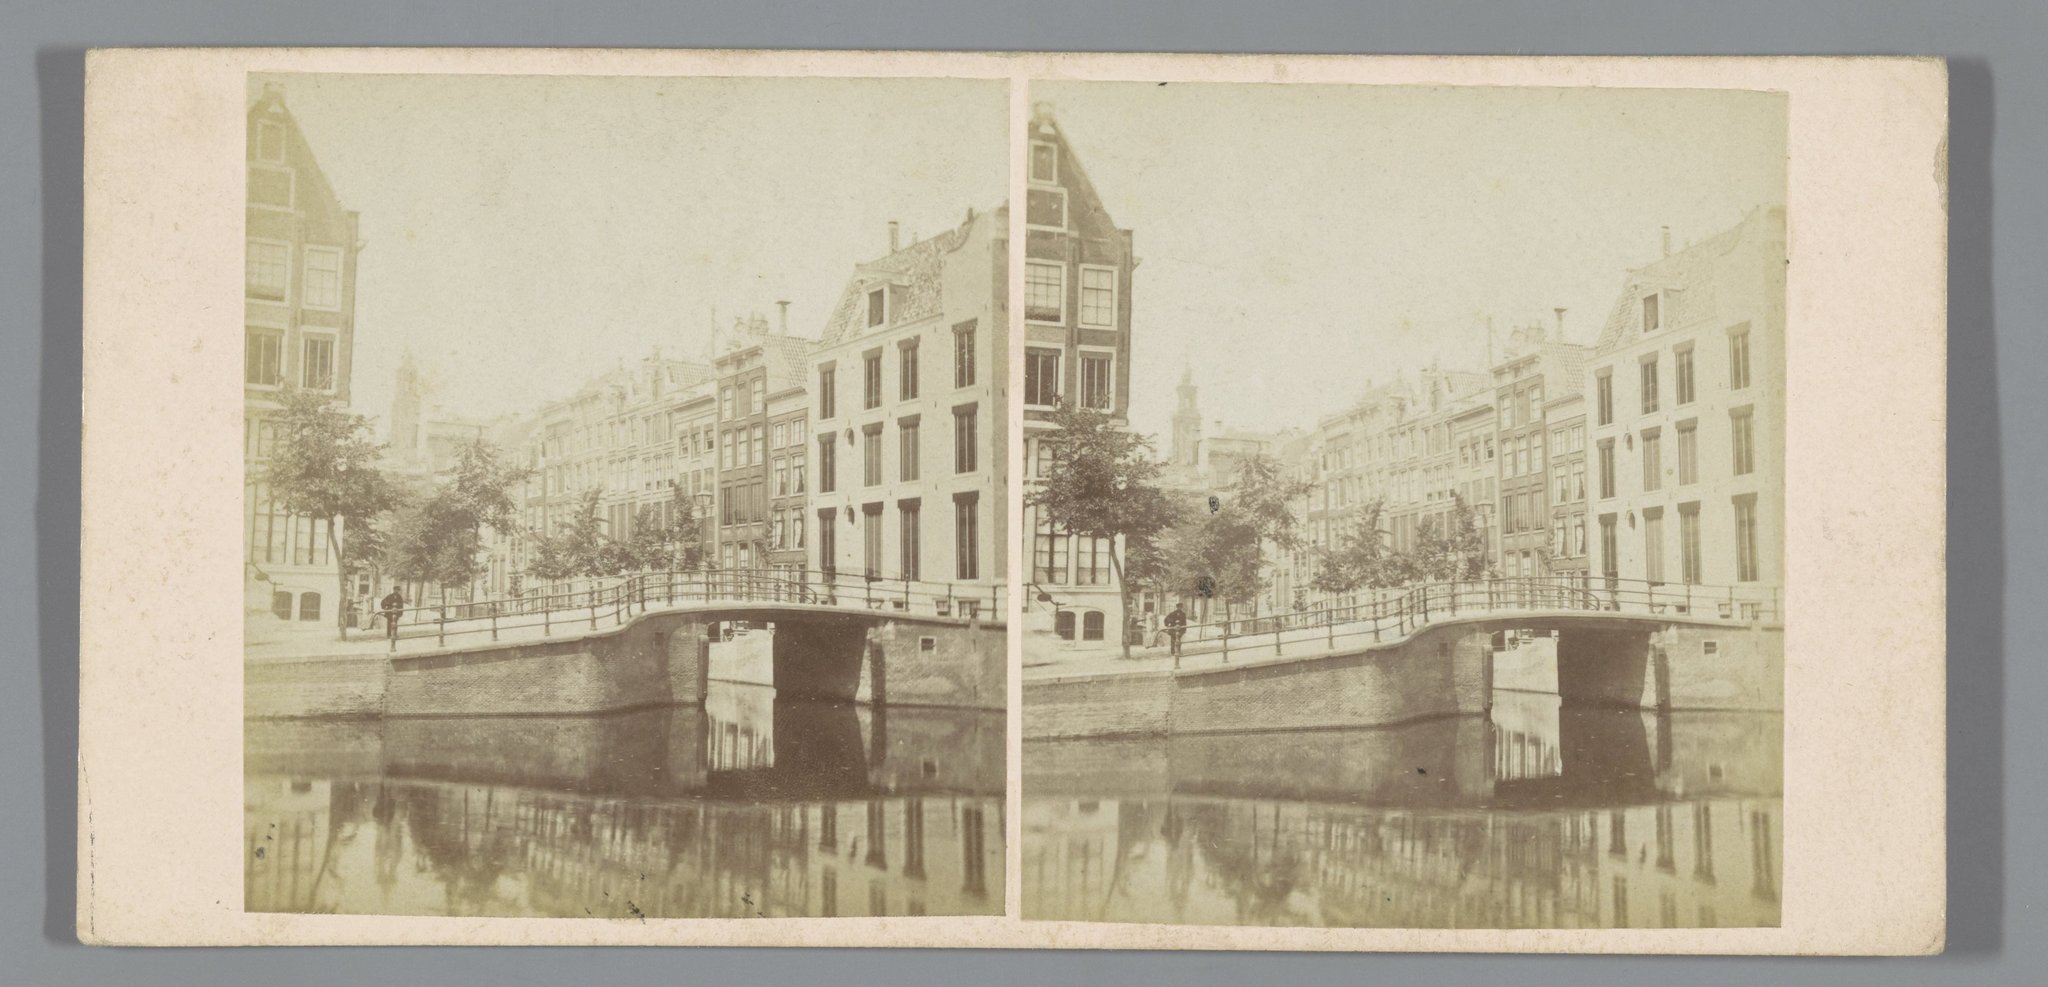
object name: stereograph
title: Gezicht op de Warmoesgracht in Amsterdam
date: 1860-1885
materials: cardboard, photographic support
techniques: albumen print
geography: amsterdam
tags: bridge in city across river, canal, etc.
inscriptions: inscription: ‘DE WARMOESGRACHT/ TE/ Amsterdam./ A. JAGER, WATER 110, TE AMSTERDAM’